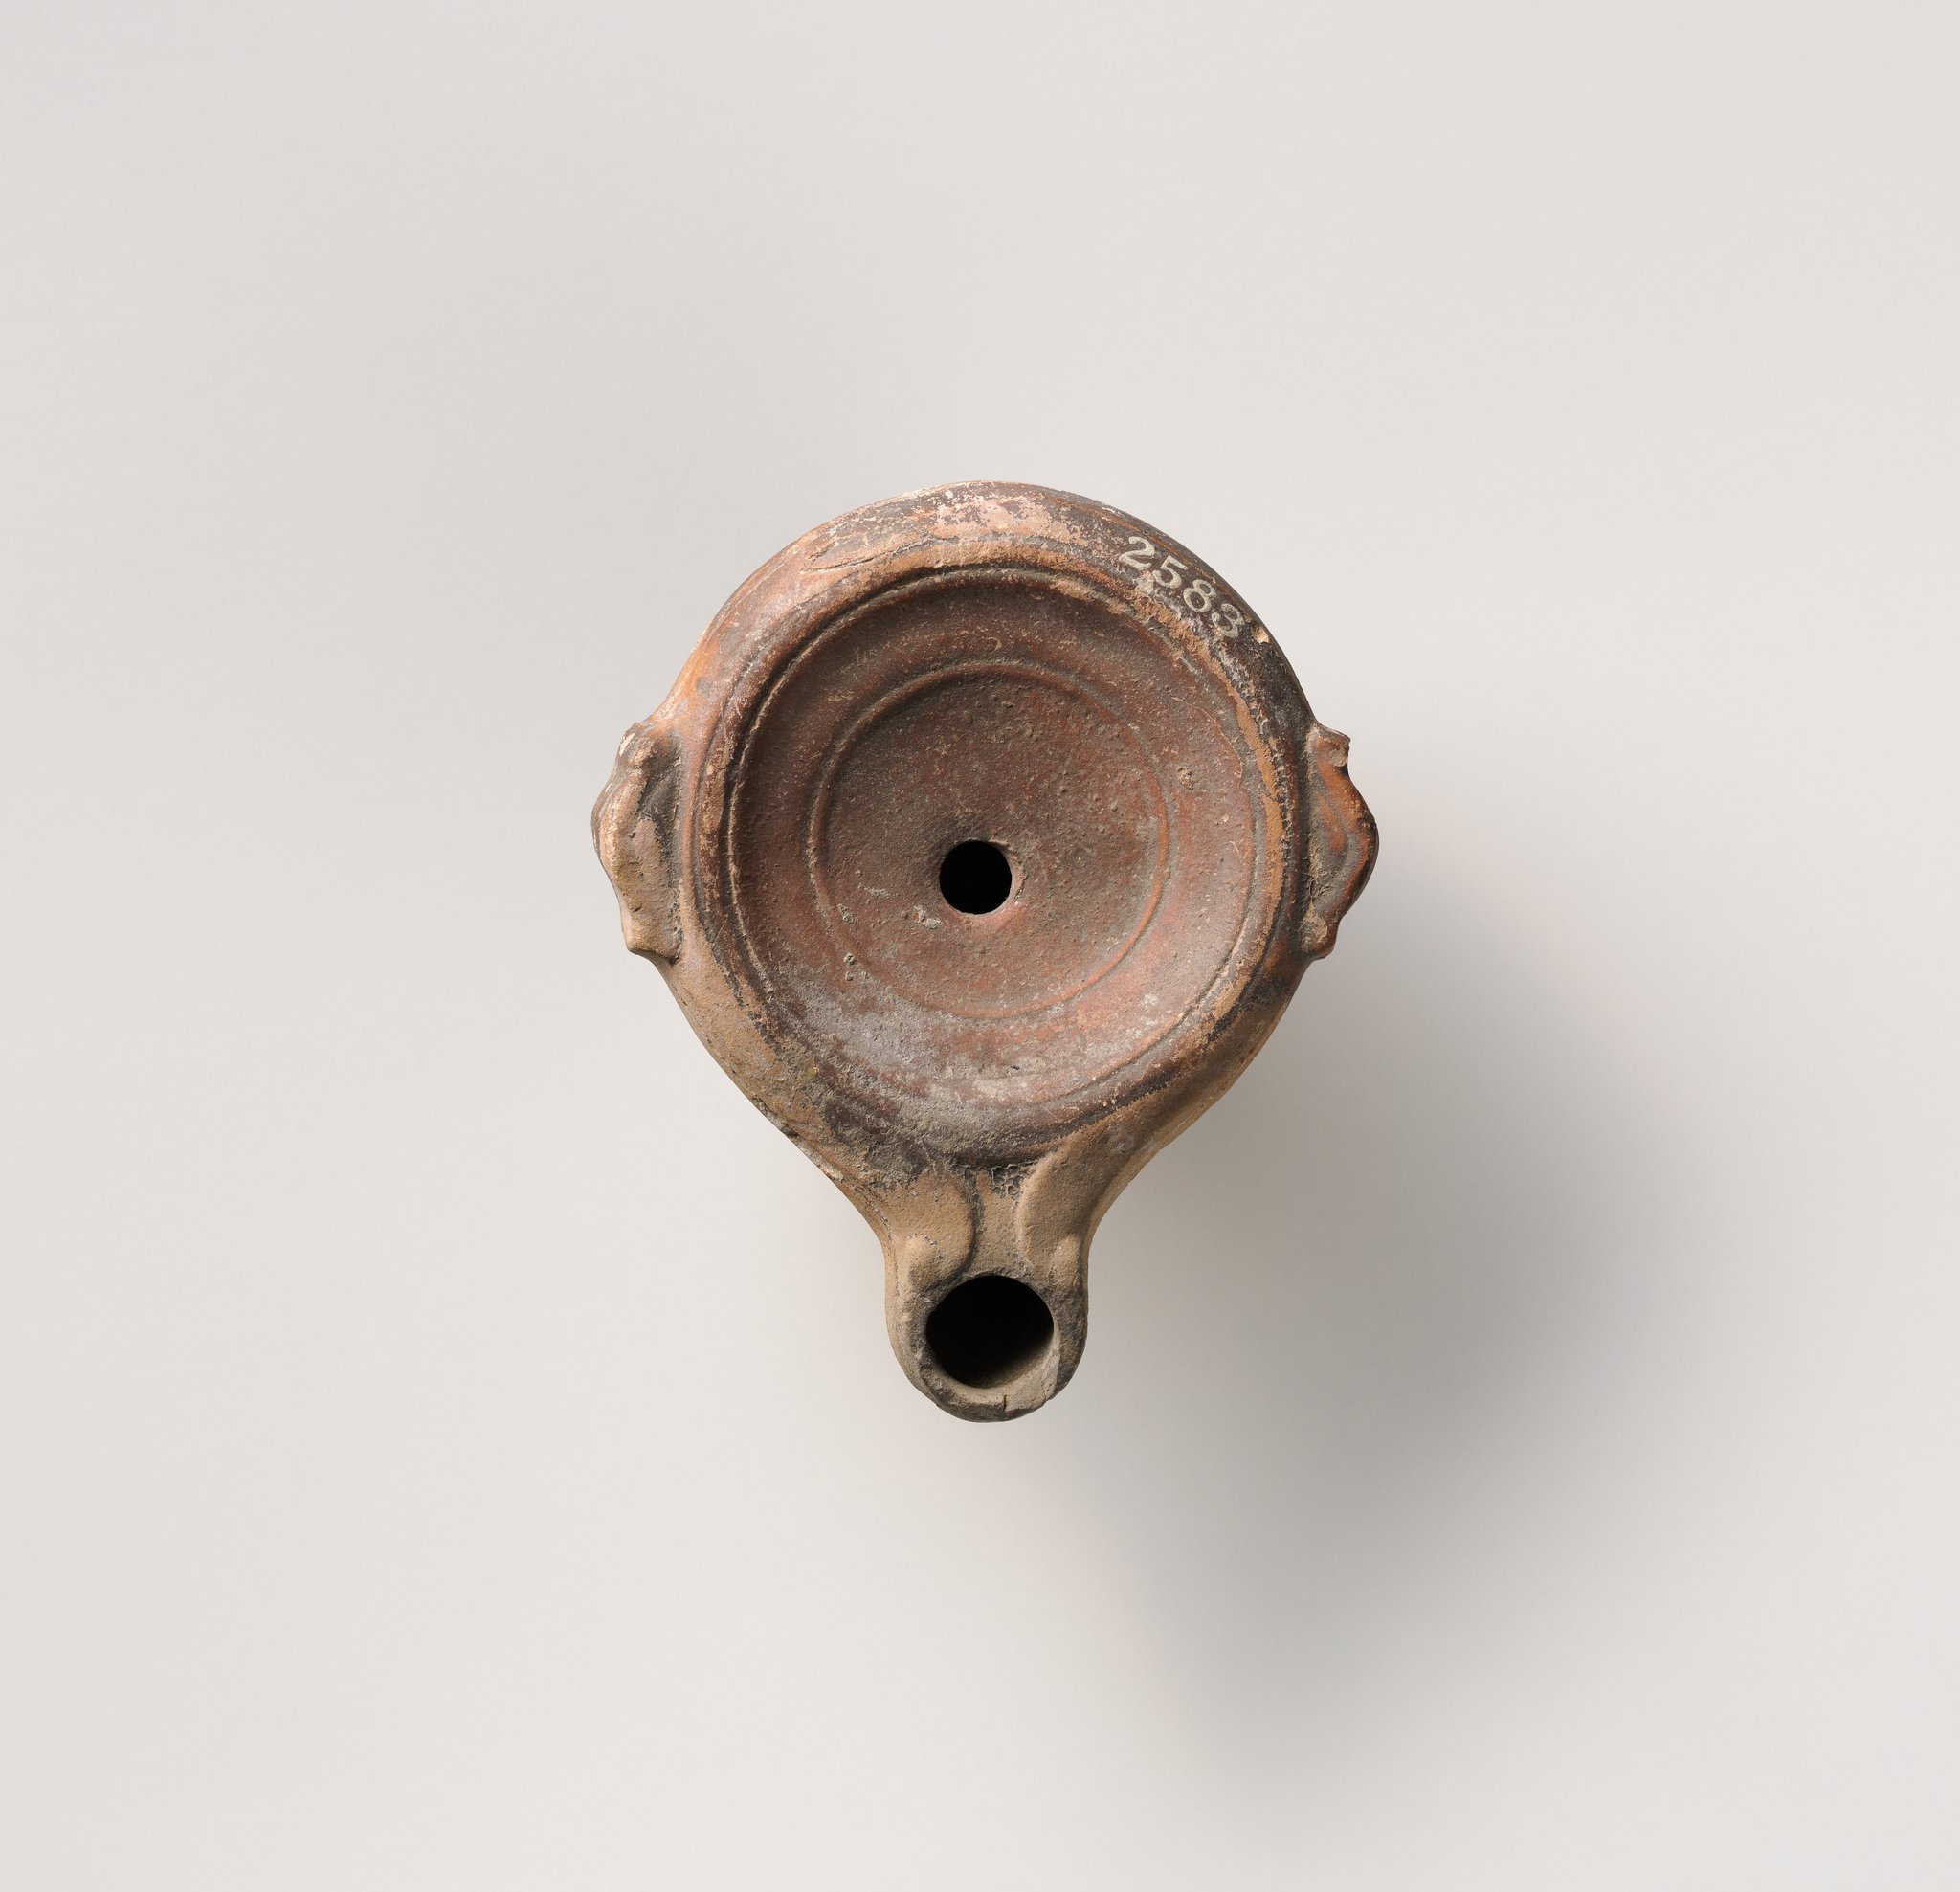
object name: lamp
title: Terracotta oil lamp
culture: roman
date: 40-100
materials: terracotta